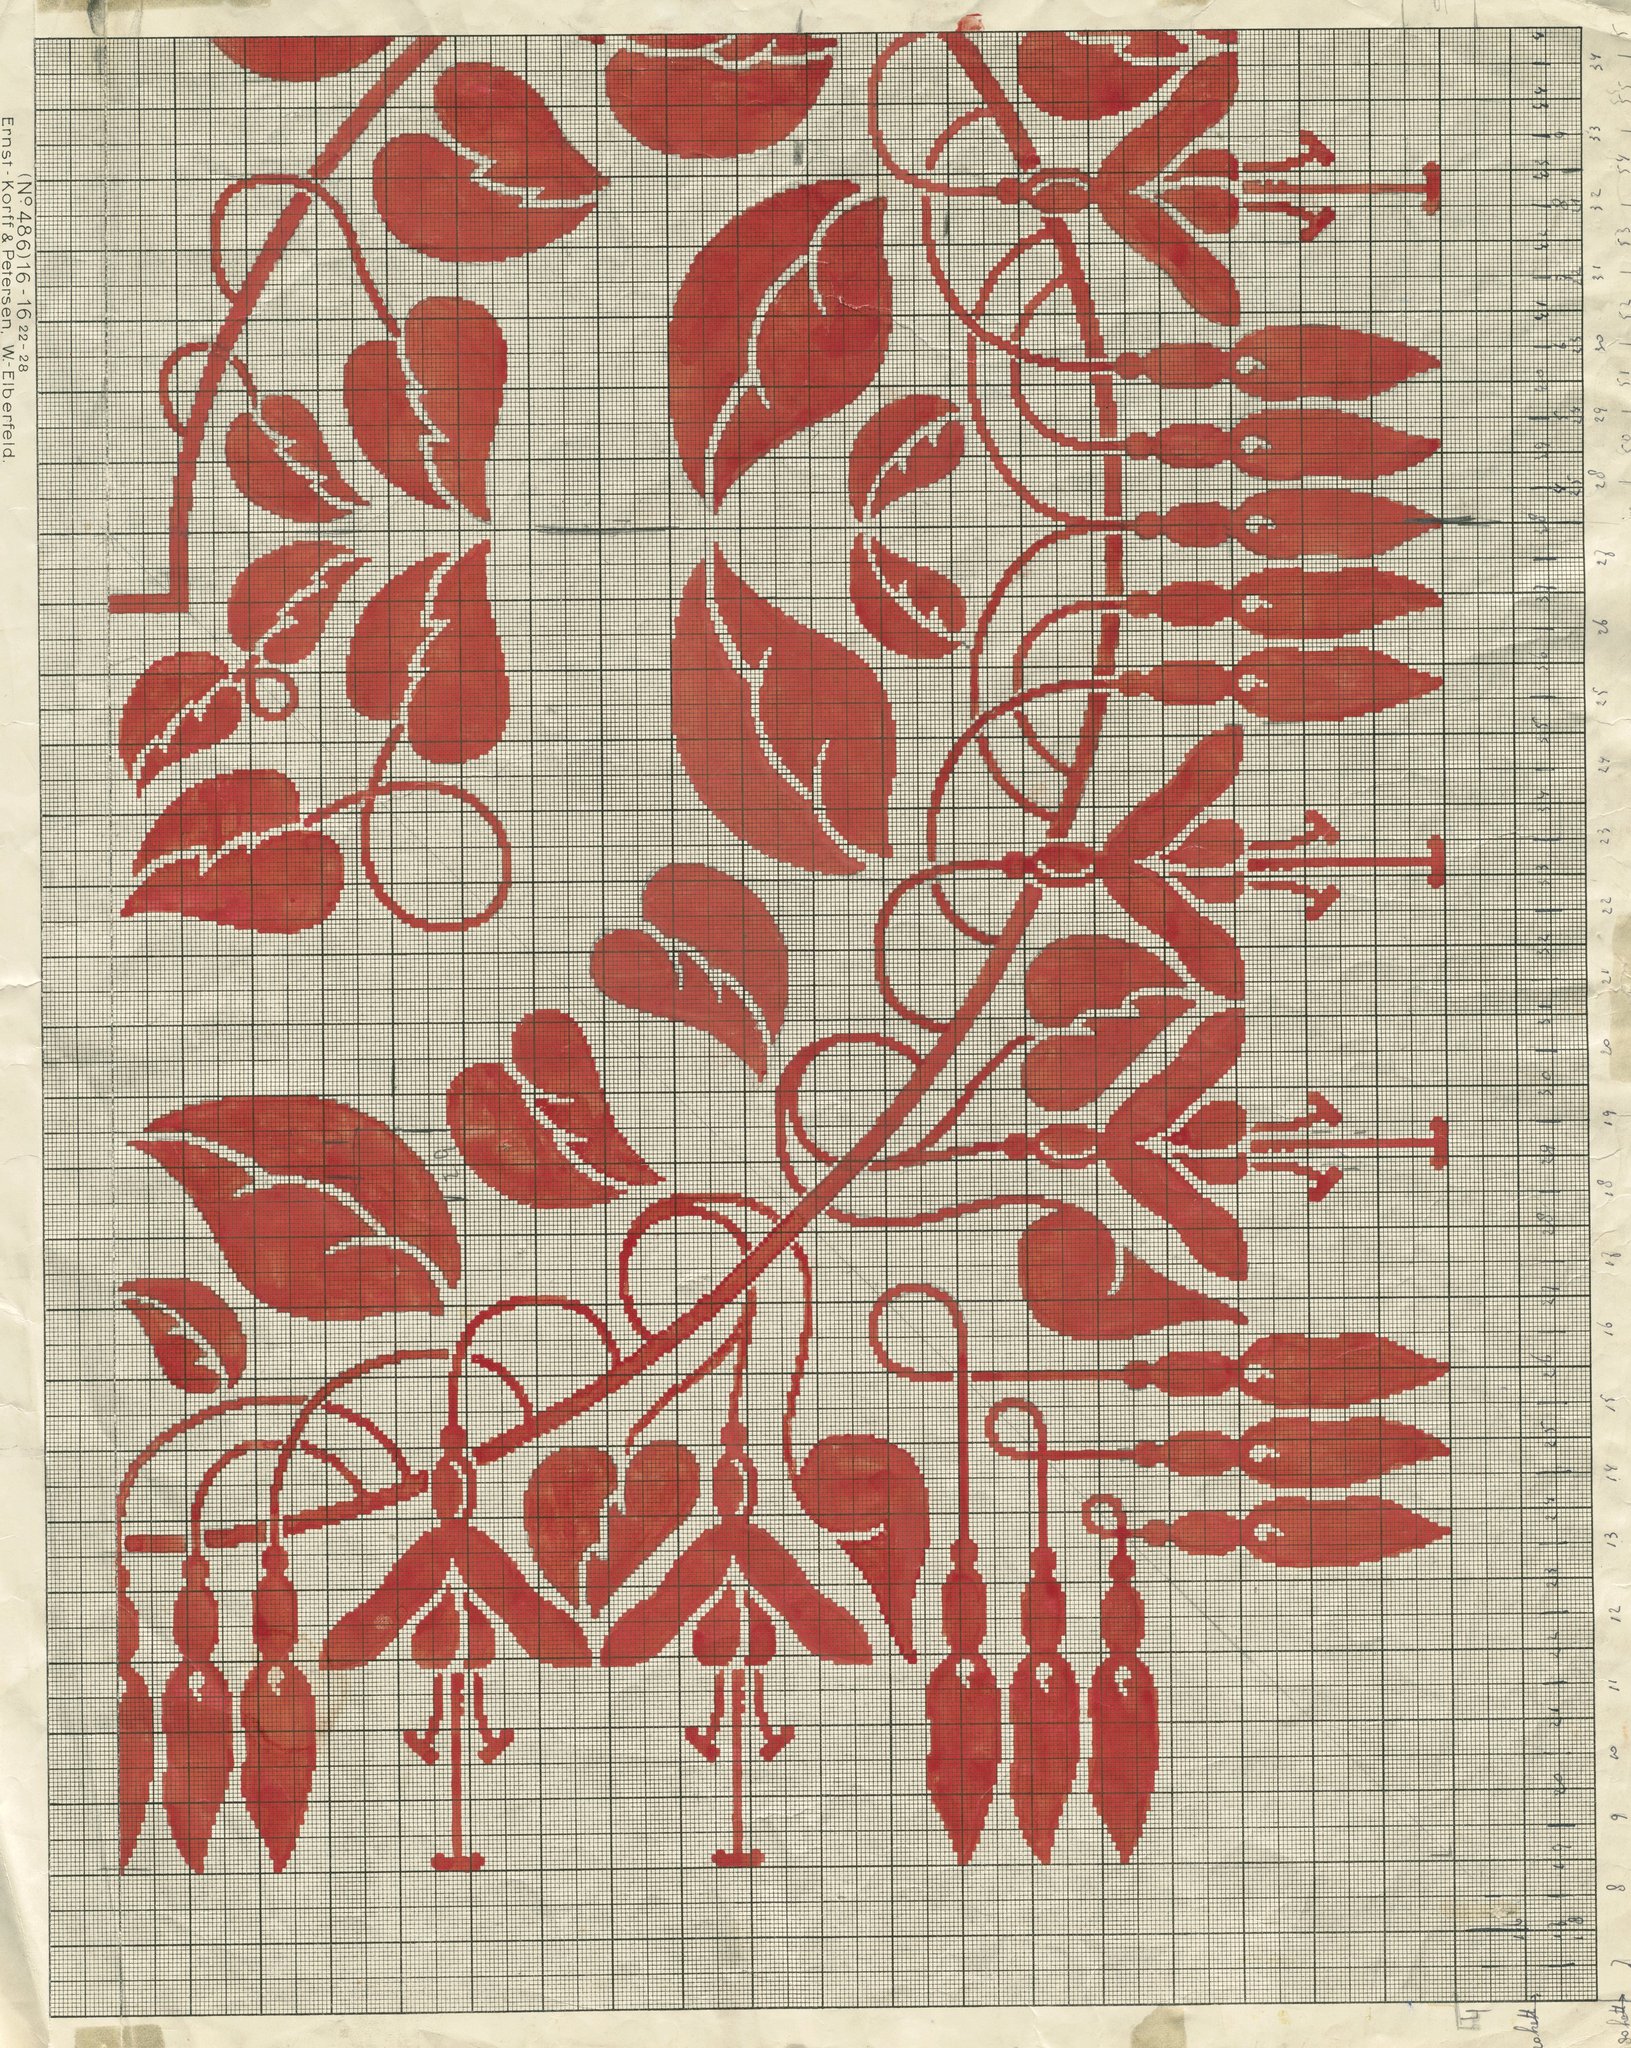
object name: patroontekening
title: Patroontekening voor een damasten tafellaken met dessin "Fuchsia" en monogram RIL (Royal Interocean Lines)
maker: cornelis van der sluys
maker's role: print maker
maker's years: 1881-1944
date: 1891-1944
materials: ink, paper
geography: eindhoven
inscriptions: annotation: ‘4420 kett // gebruikt in 140x260’, annotation: ‘Tafellaken 501A 160cm // 5180 kett // ingeweven // RIL in kapitelen met kroon en jaartal’, annotation: ‘Tafell A62/501 140cm // 4420 kett // ingeweven // RIL met kroon en jaart’, annotation: ‘voor monogram zie // tafell 501A 8/4’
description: Patroontekening in rode inkt voor een damasten tafellaken, in 4 delen, A t/m D. De delen A en B passen op twee manieren aan elkaar en tonen het hoek/randpatroon van enigszins gestileerde lange, golvende twijgen met fuchsiabloemen, knoppen en bladeren. Op deel B meerdere malen de monogrammen R.I.L. (Royal Interocean Lines) en R.I.L. D, en de cijfers 63, 65, 4, 5 en 6 om jaartallen mee te vormen. Deel C is een gedeeltelijke herhaling van het randpatroon, uitgevoerd in een donkerder kleur rood. Deel D is het patroon voor het middenveld, met losse bloemen en bladeren, met veel pijlen en weefaanwijzingen in potlood. Dit deel sluit niet aan bij de andere delen. Dessin 501.